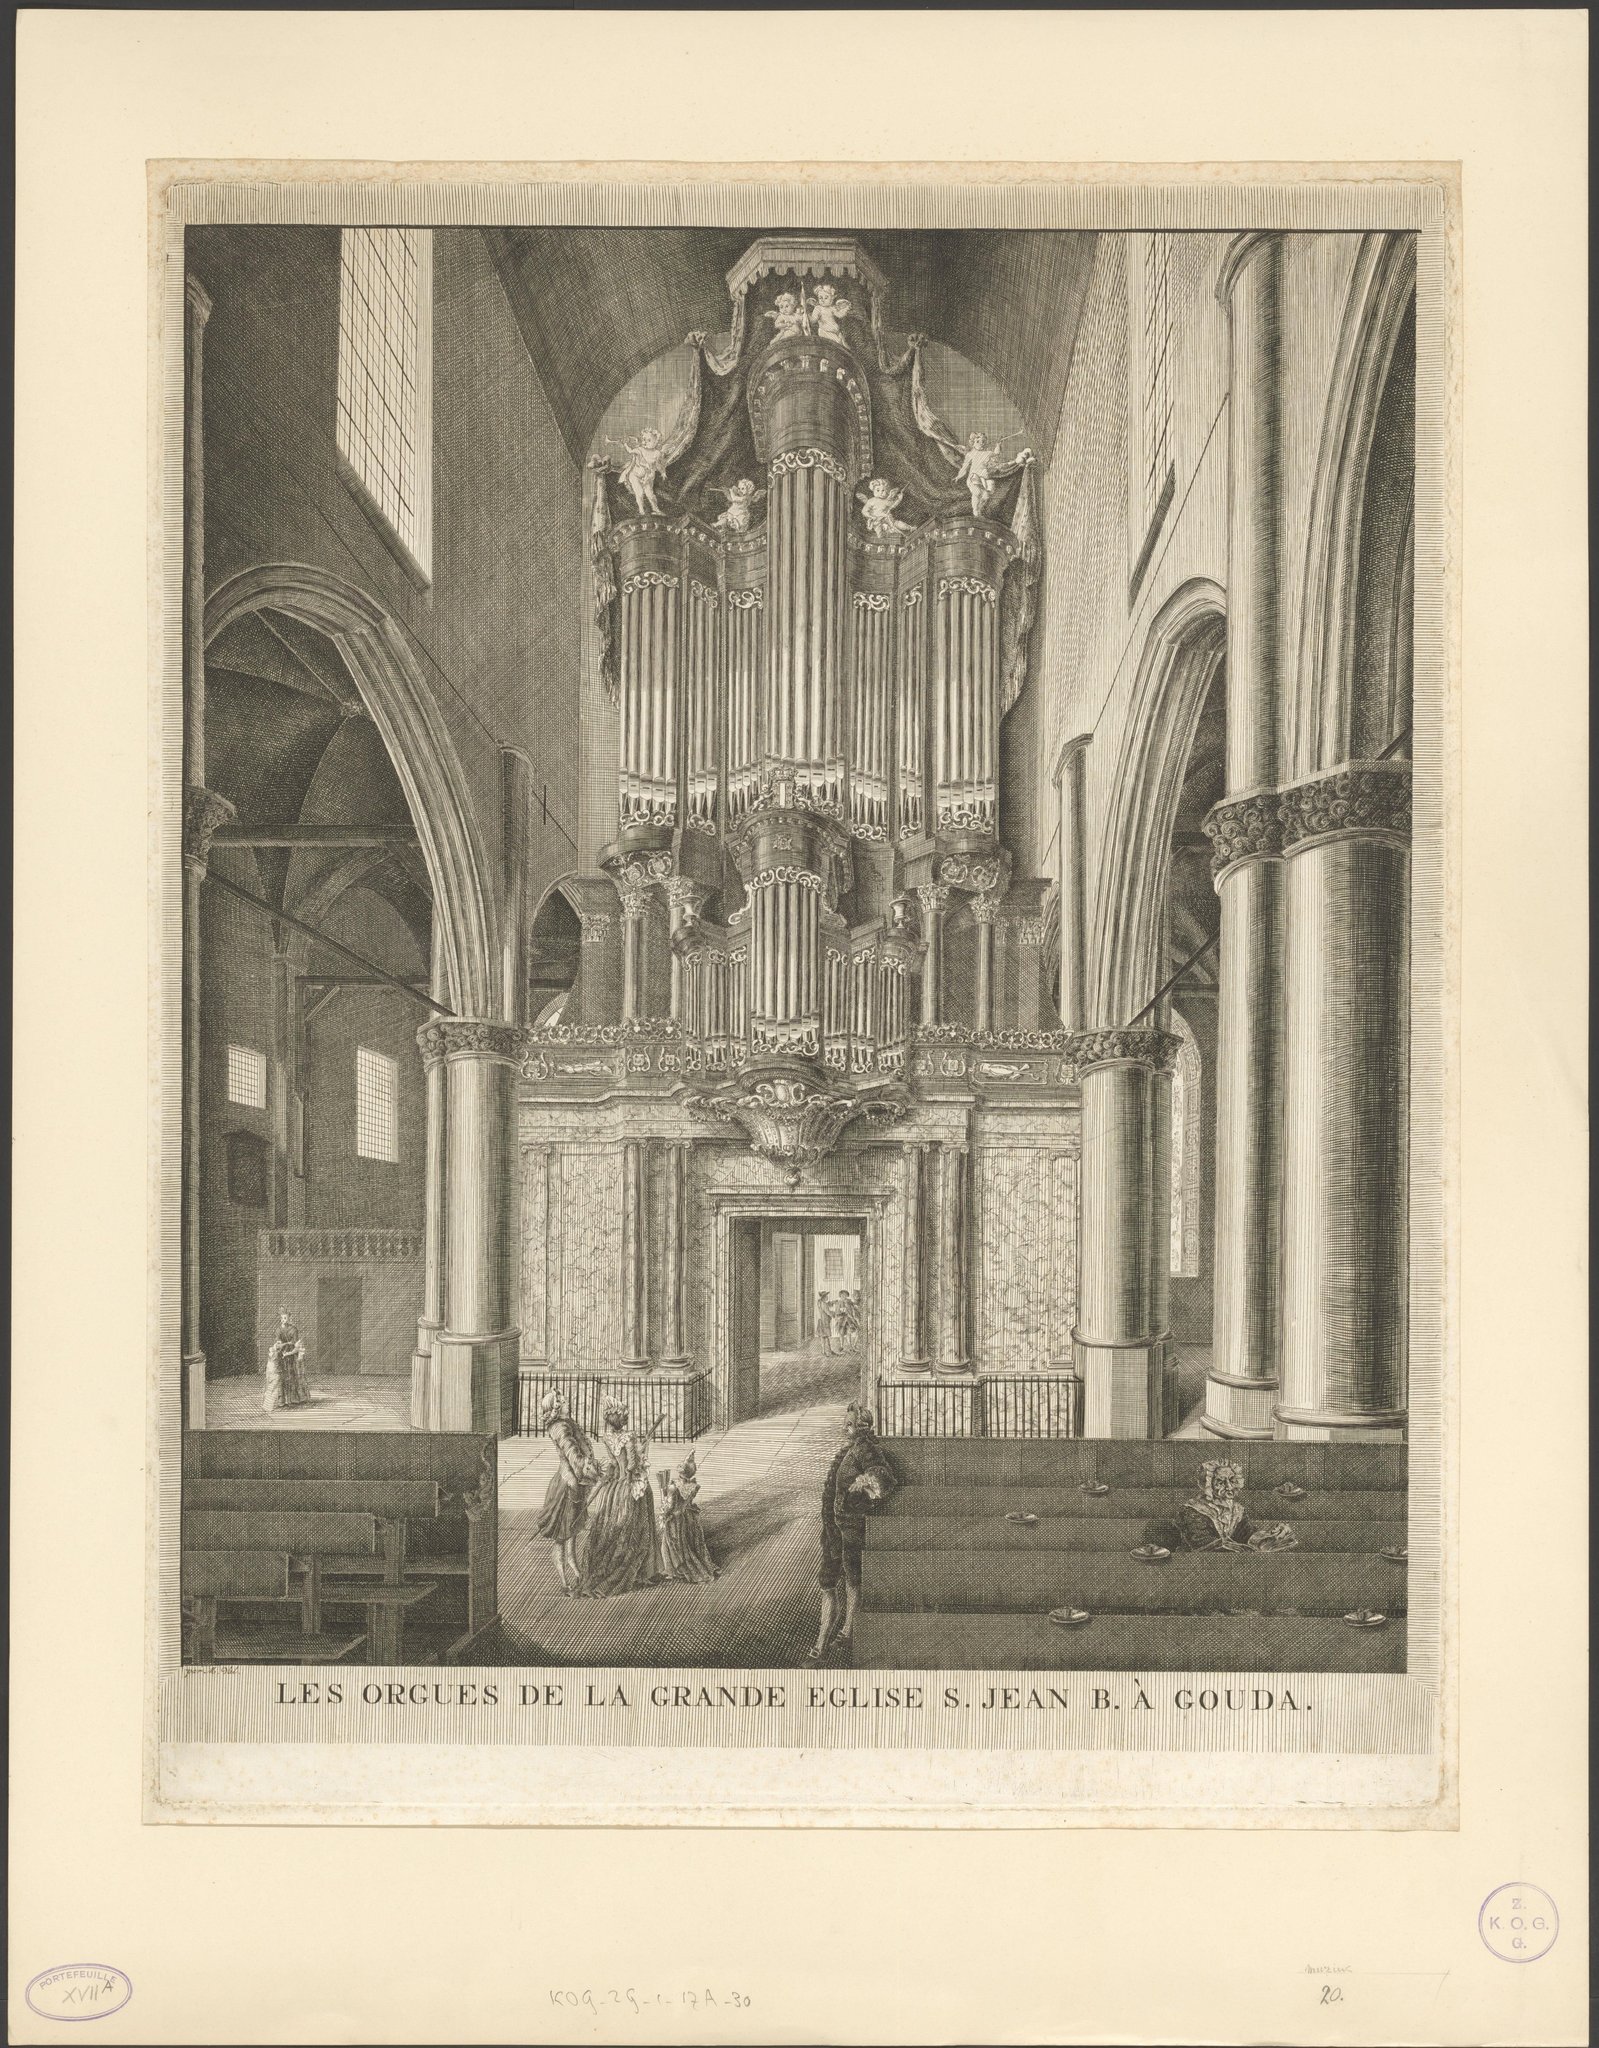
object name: print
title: Les orgues de la grande eglise S. Jean B. à Gouda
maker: auguste moreau val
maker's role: draughtsman, print maker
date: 1770-1775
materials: paper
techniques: engraving, etching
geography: netherlands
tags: church organ, interior of church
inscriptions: stamp, collector's mark: Lugt 1641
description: Kerkinterieur met gezicht op het orgel in de Sint-Janskerk te Gouda. Met verschillende figuren. Onderwerpsrubrieken binnen de Atlas Zeden en Gewoonten: Muziek en muziekinstrumenten: Kerkorgels.